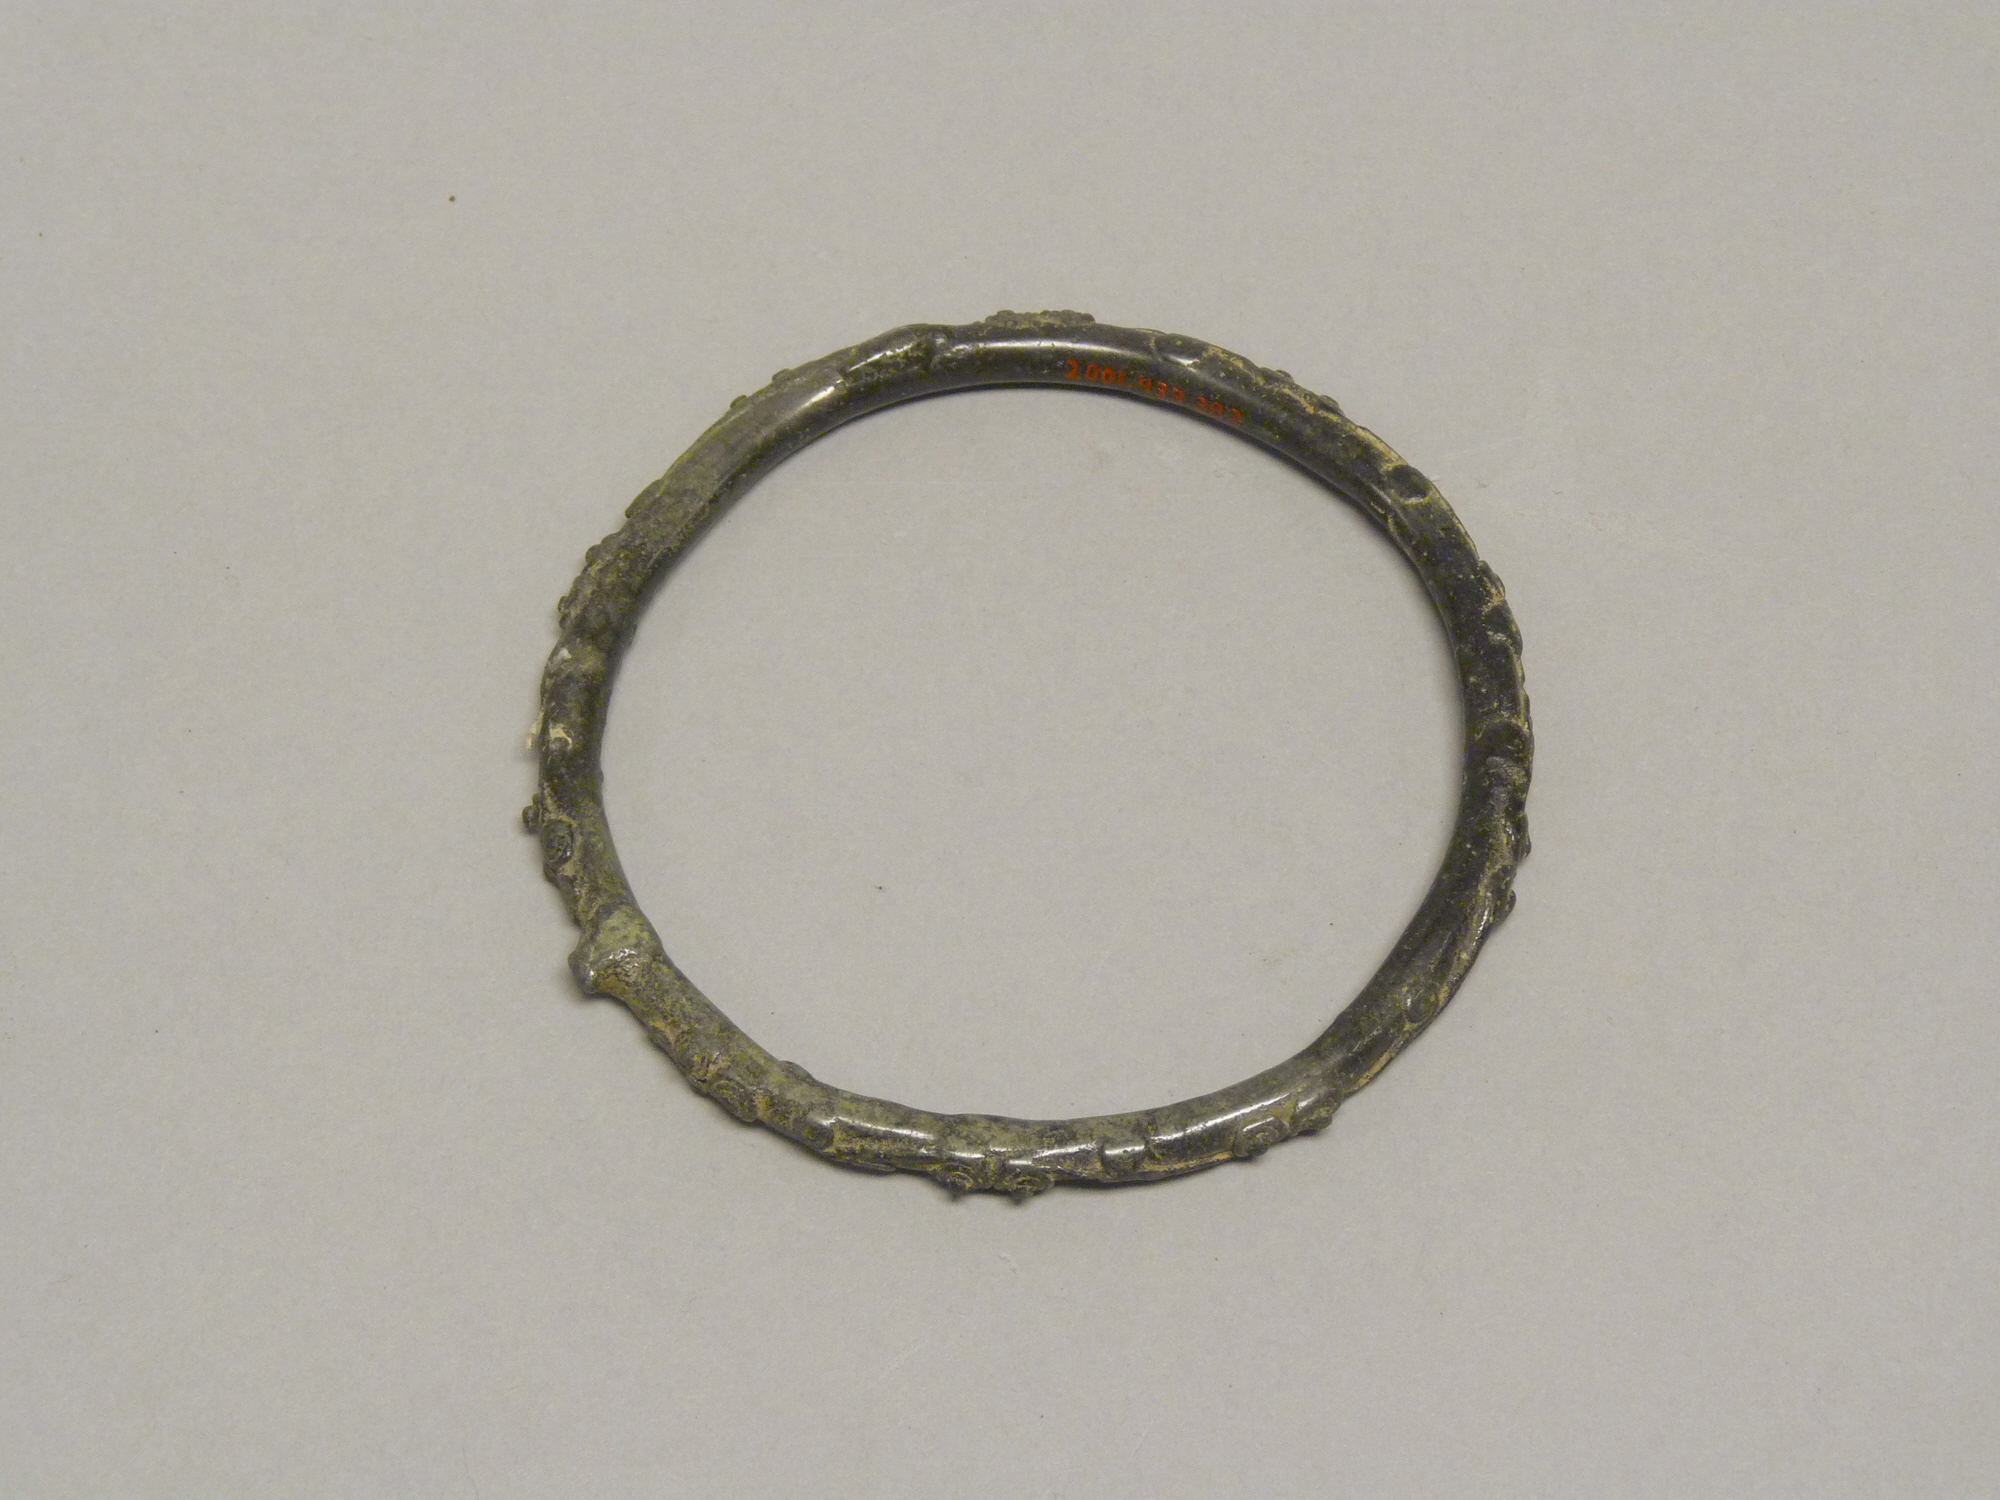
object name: anklet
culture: vietnamese, north, highlands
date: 500 BCE-300 CE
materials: bronze